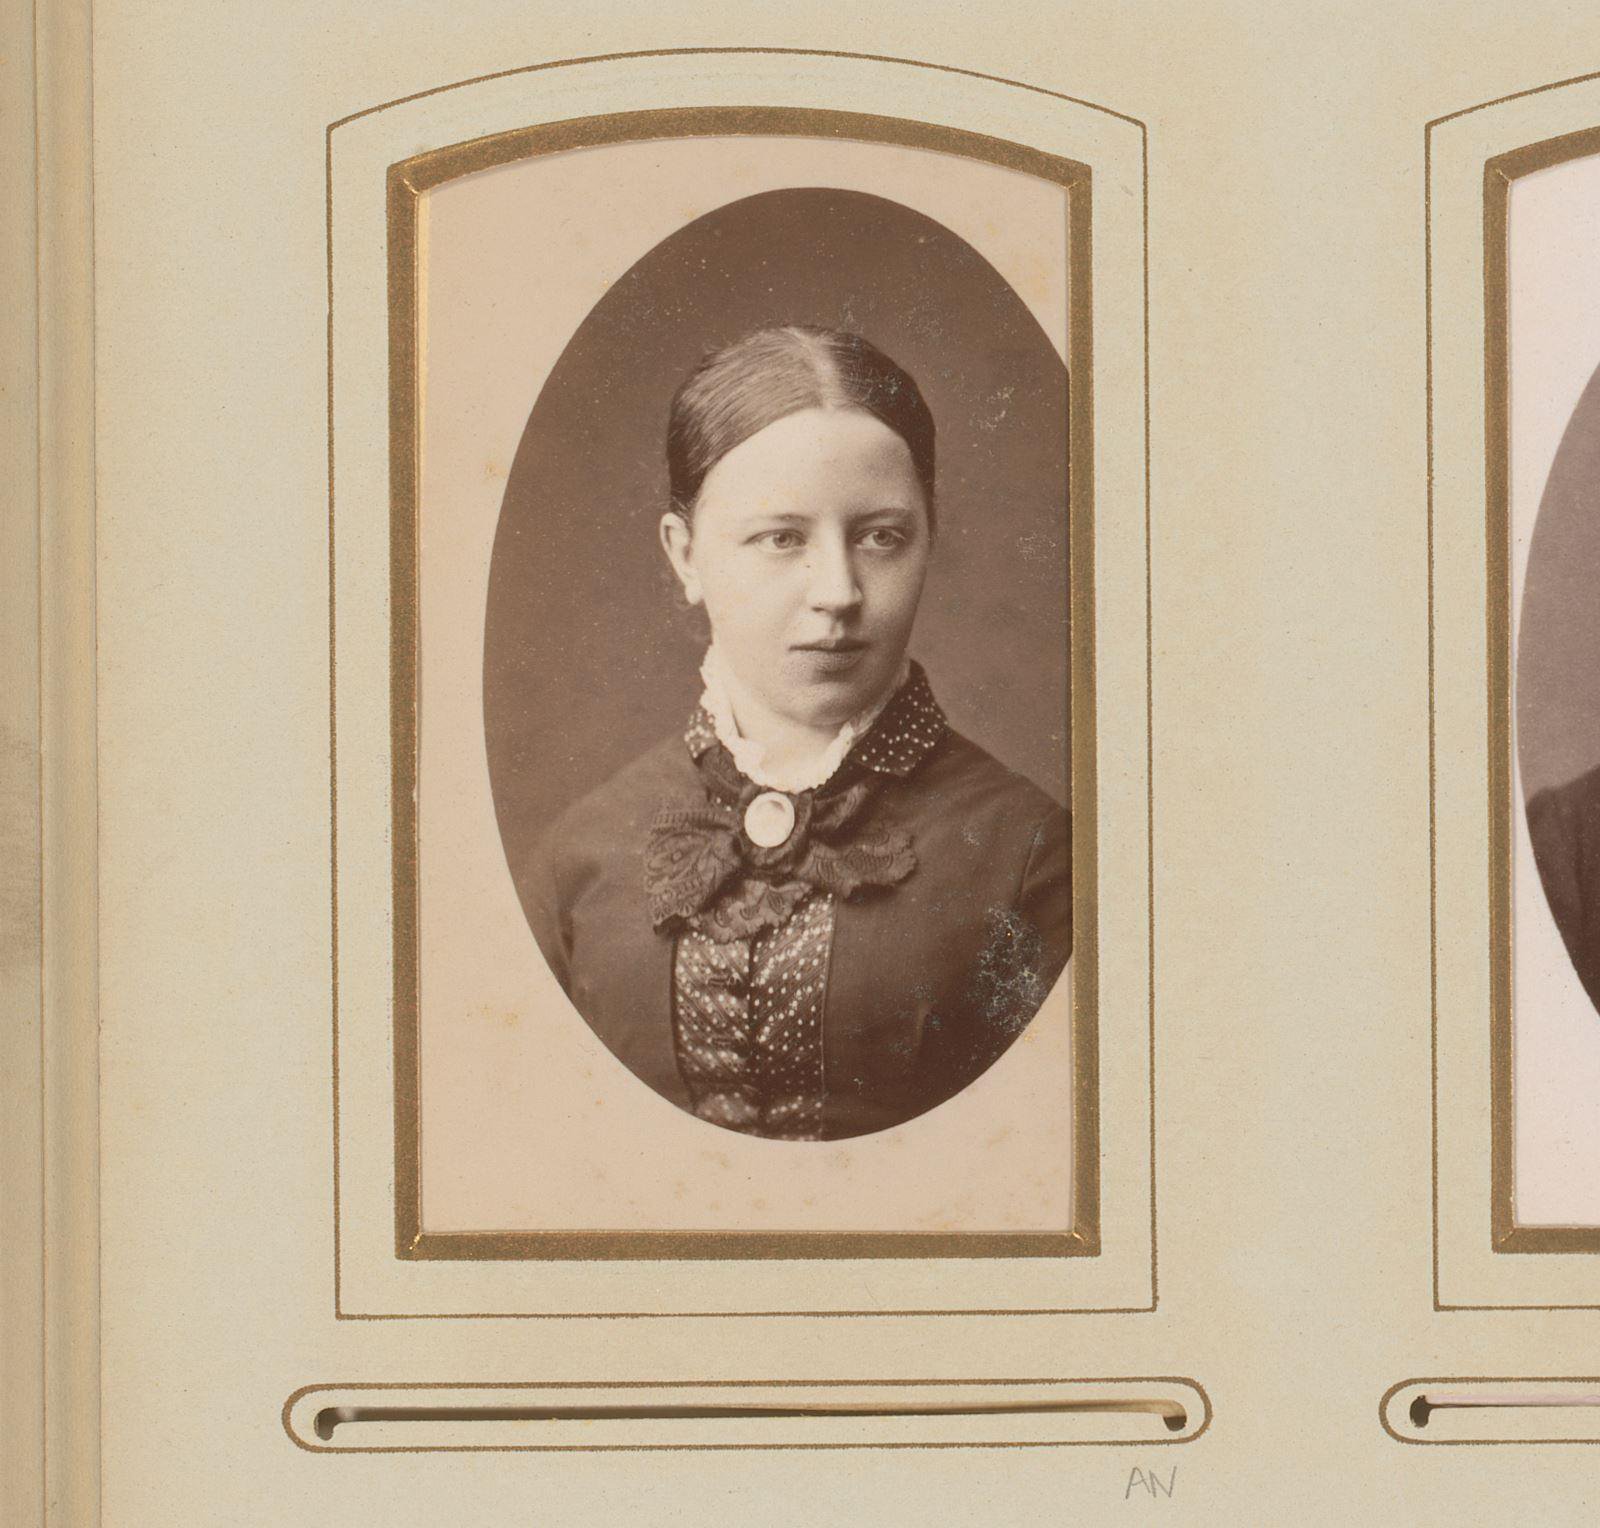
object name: album leaf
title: Portret van een jonge vrouw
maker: fritz eilender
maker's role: fotograaf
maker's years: -1905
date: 1882-1904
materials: cardboard, photographic support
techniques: albumen print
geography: cologne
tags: adolescent, young woman, maiden, historical persons - bb - woman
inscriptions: inscription: ‘Fritz Eilender/ CÖLN/ Breitestrasse 86.’